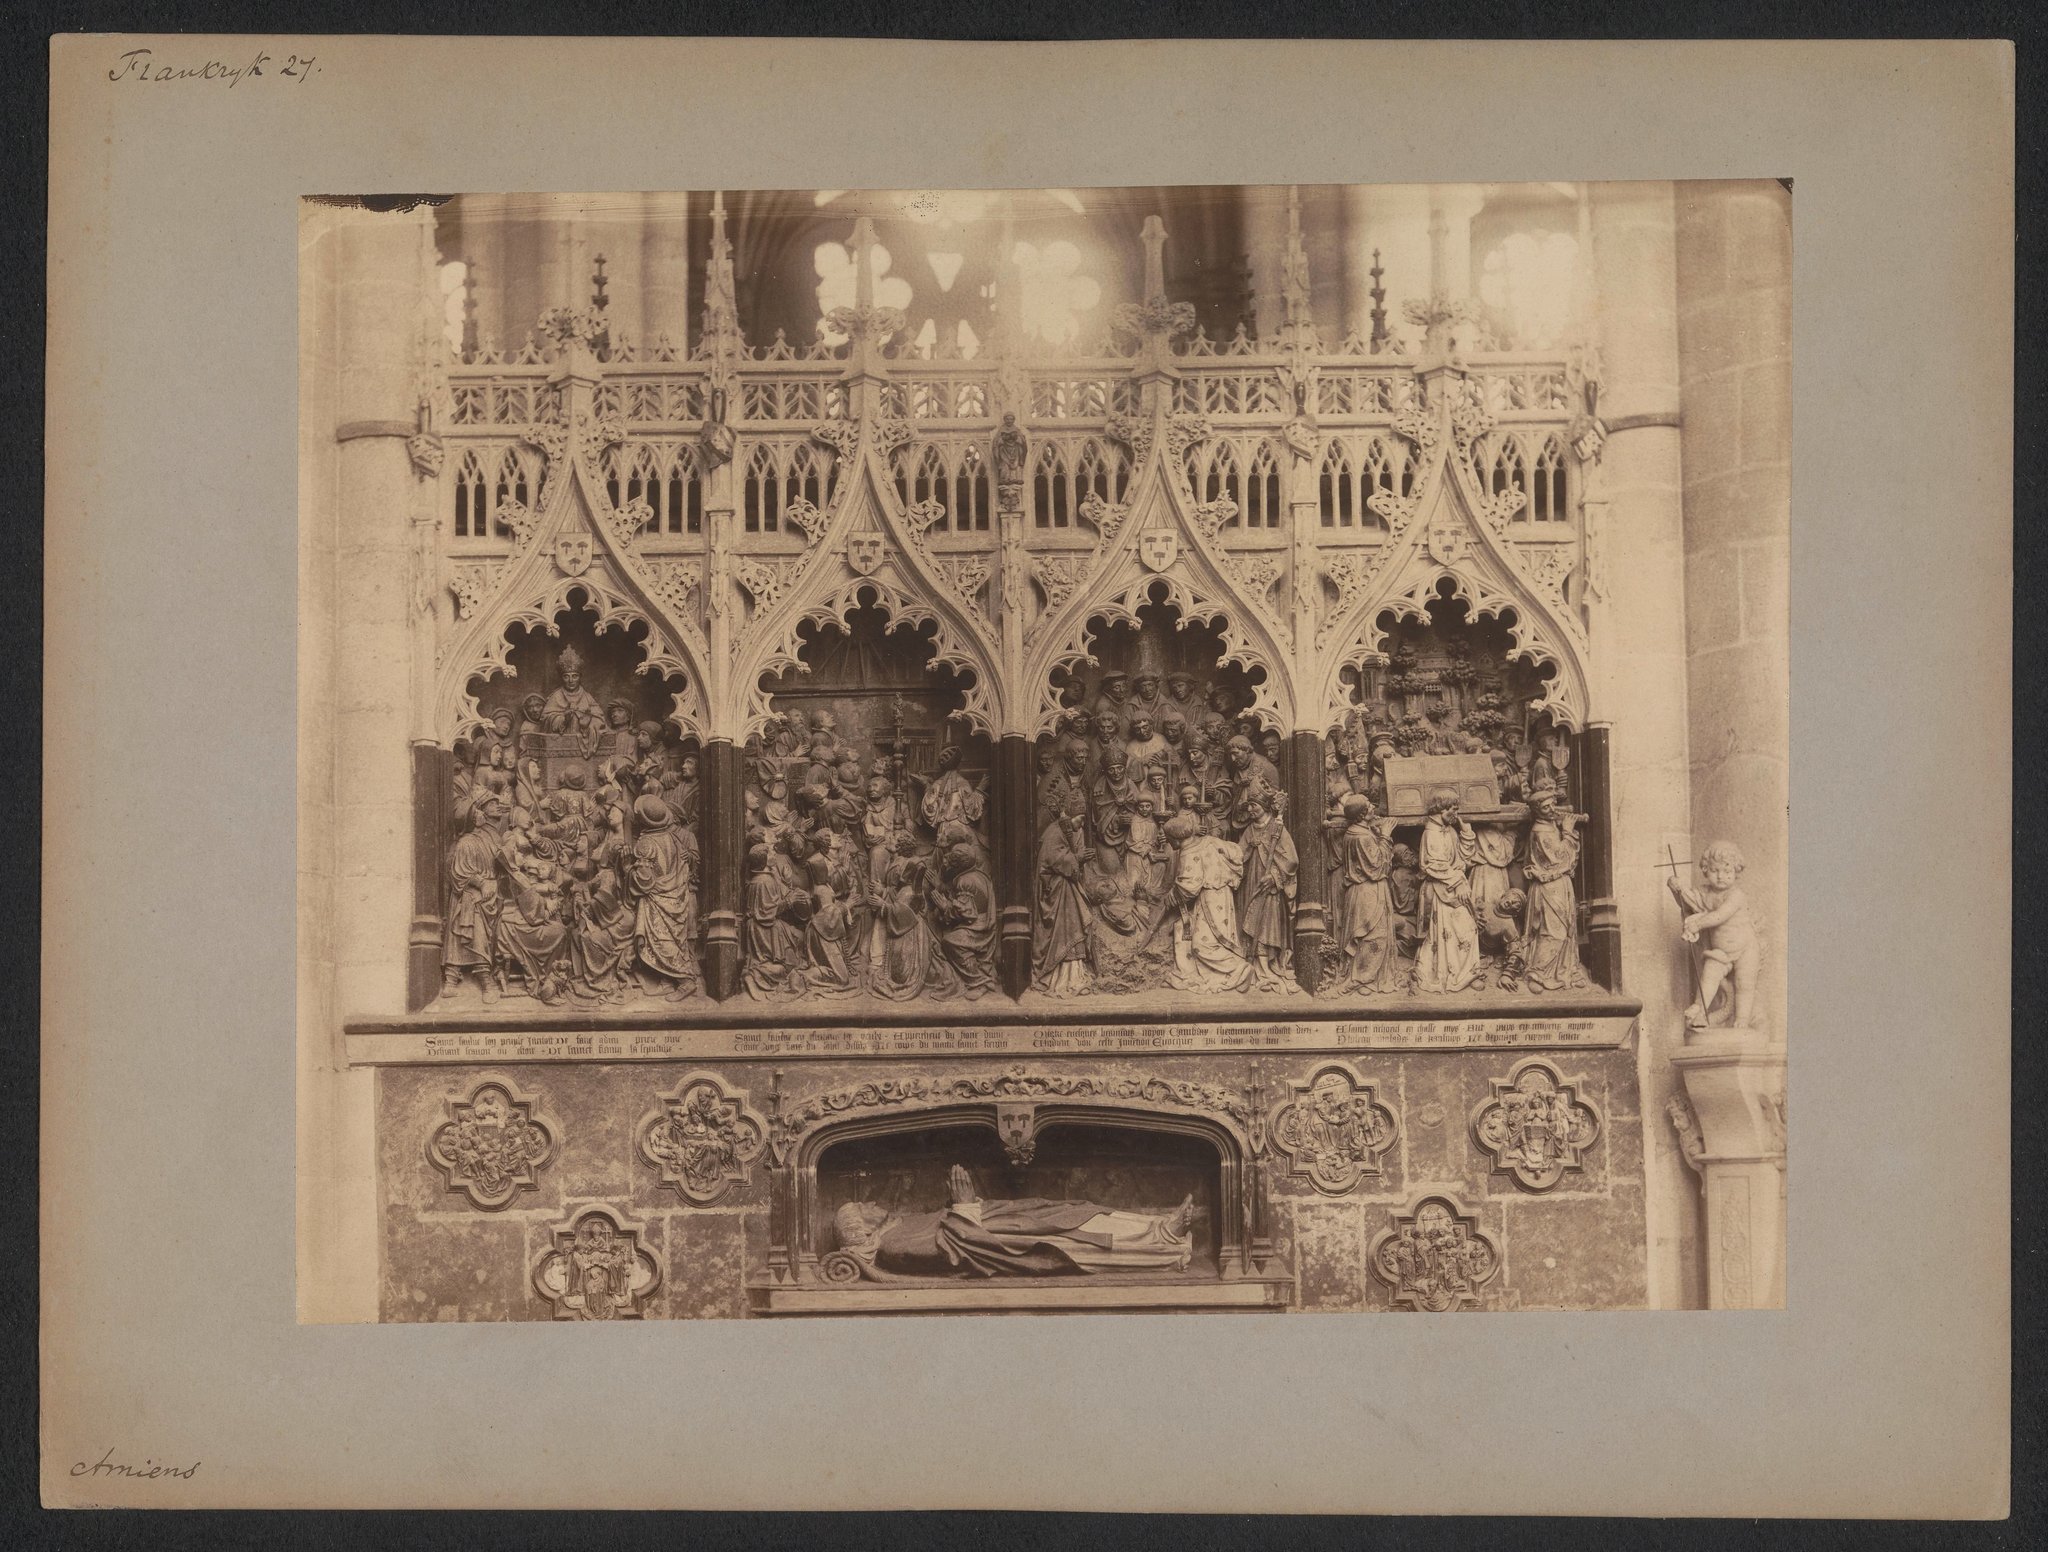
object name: photograph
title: Tombe van een bisschop in de Notre-Dame in Amiens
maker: Anonymous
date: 1850-1900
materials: cardboard, photographic support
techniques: albumen print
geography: notre-dame d'amiens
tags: grave, tomb, interior of church, notre-dame d'amiens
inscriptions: annotation: ‘Amiens’, annotation: ‘Amiens’, annotation: ‘Frankrijk 27.’, collector's mark: ‘RIJKS NORMAALSCHOOL voor TE[EKENONDERWIJZERS] AMSTERDAM’